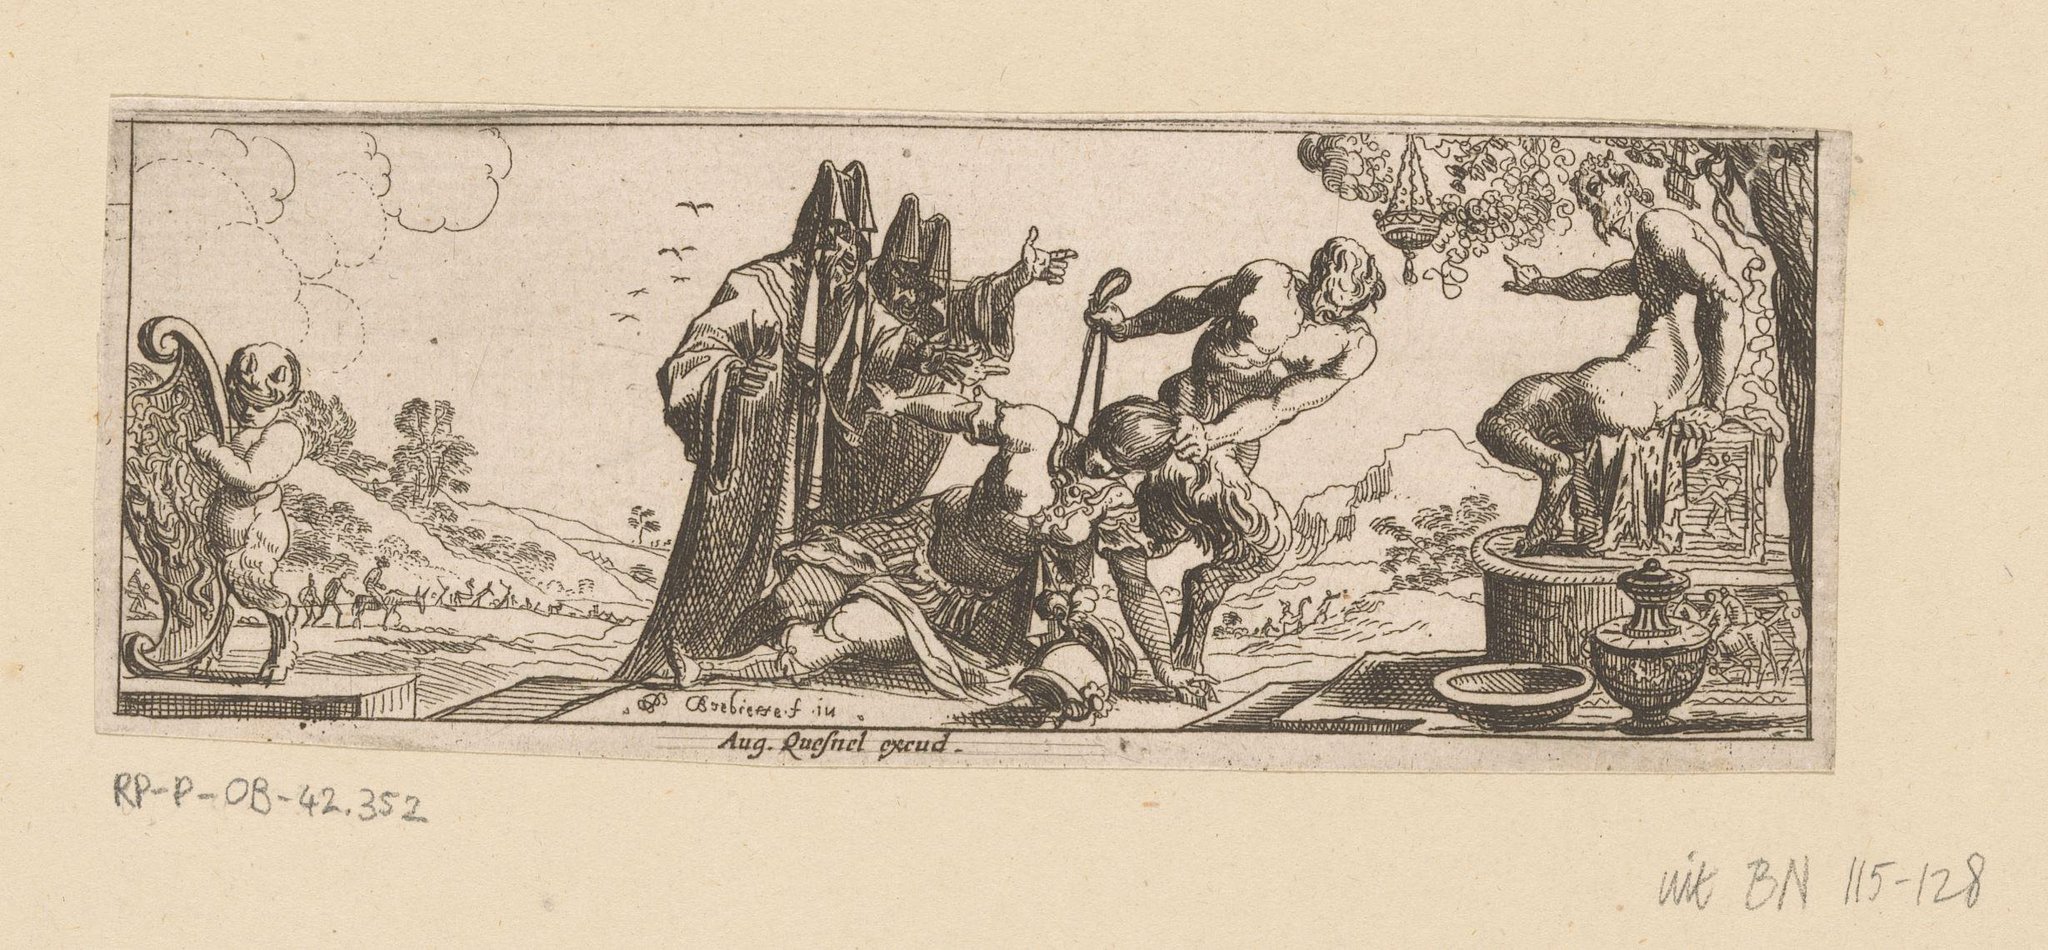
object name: print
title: Amazone door saters voor Pan gebracht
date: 1608-1650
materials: paper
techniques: etching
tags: (story of) the amazons - suffering, misfortune, (story of) pan, satyr(s) (in general) - aggressive, unfriendly activities and relationships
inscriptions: collector's mark: Lugt 240